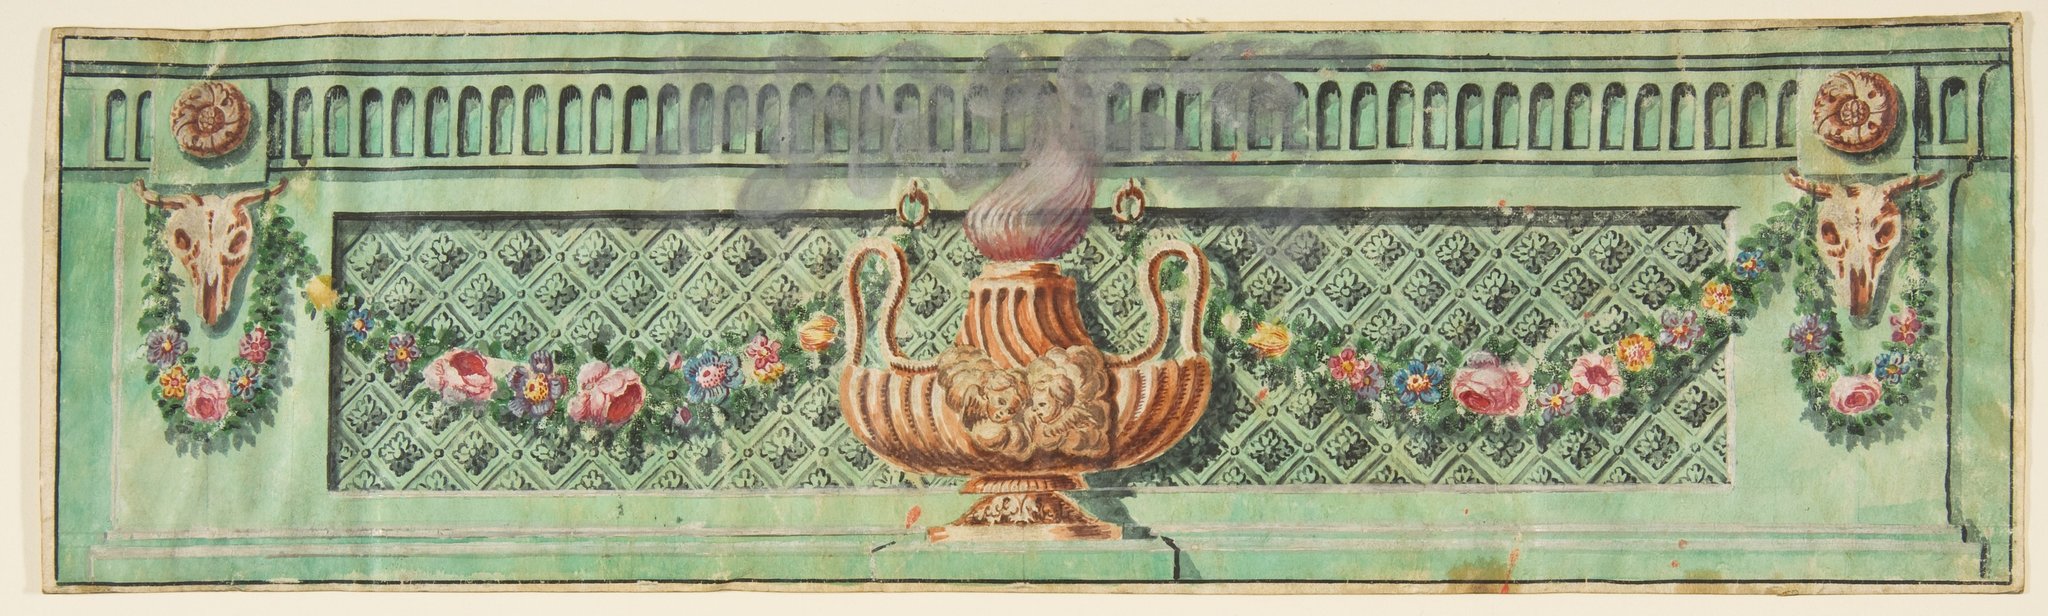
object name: drawing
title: Ornamental Panel with Flaming Lamp and Floral Swags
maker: anonymous, french, 19th century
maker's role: artist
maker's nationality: french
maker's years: 1800-1900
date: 1801-1900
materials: parchment, watercolor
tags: garlands,lamps